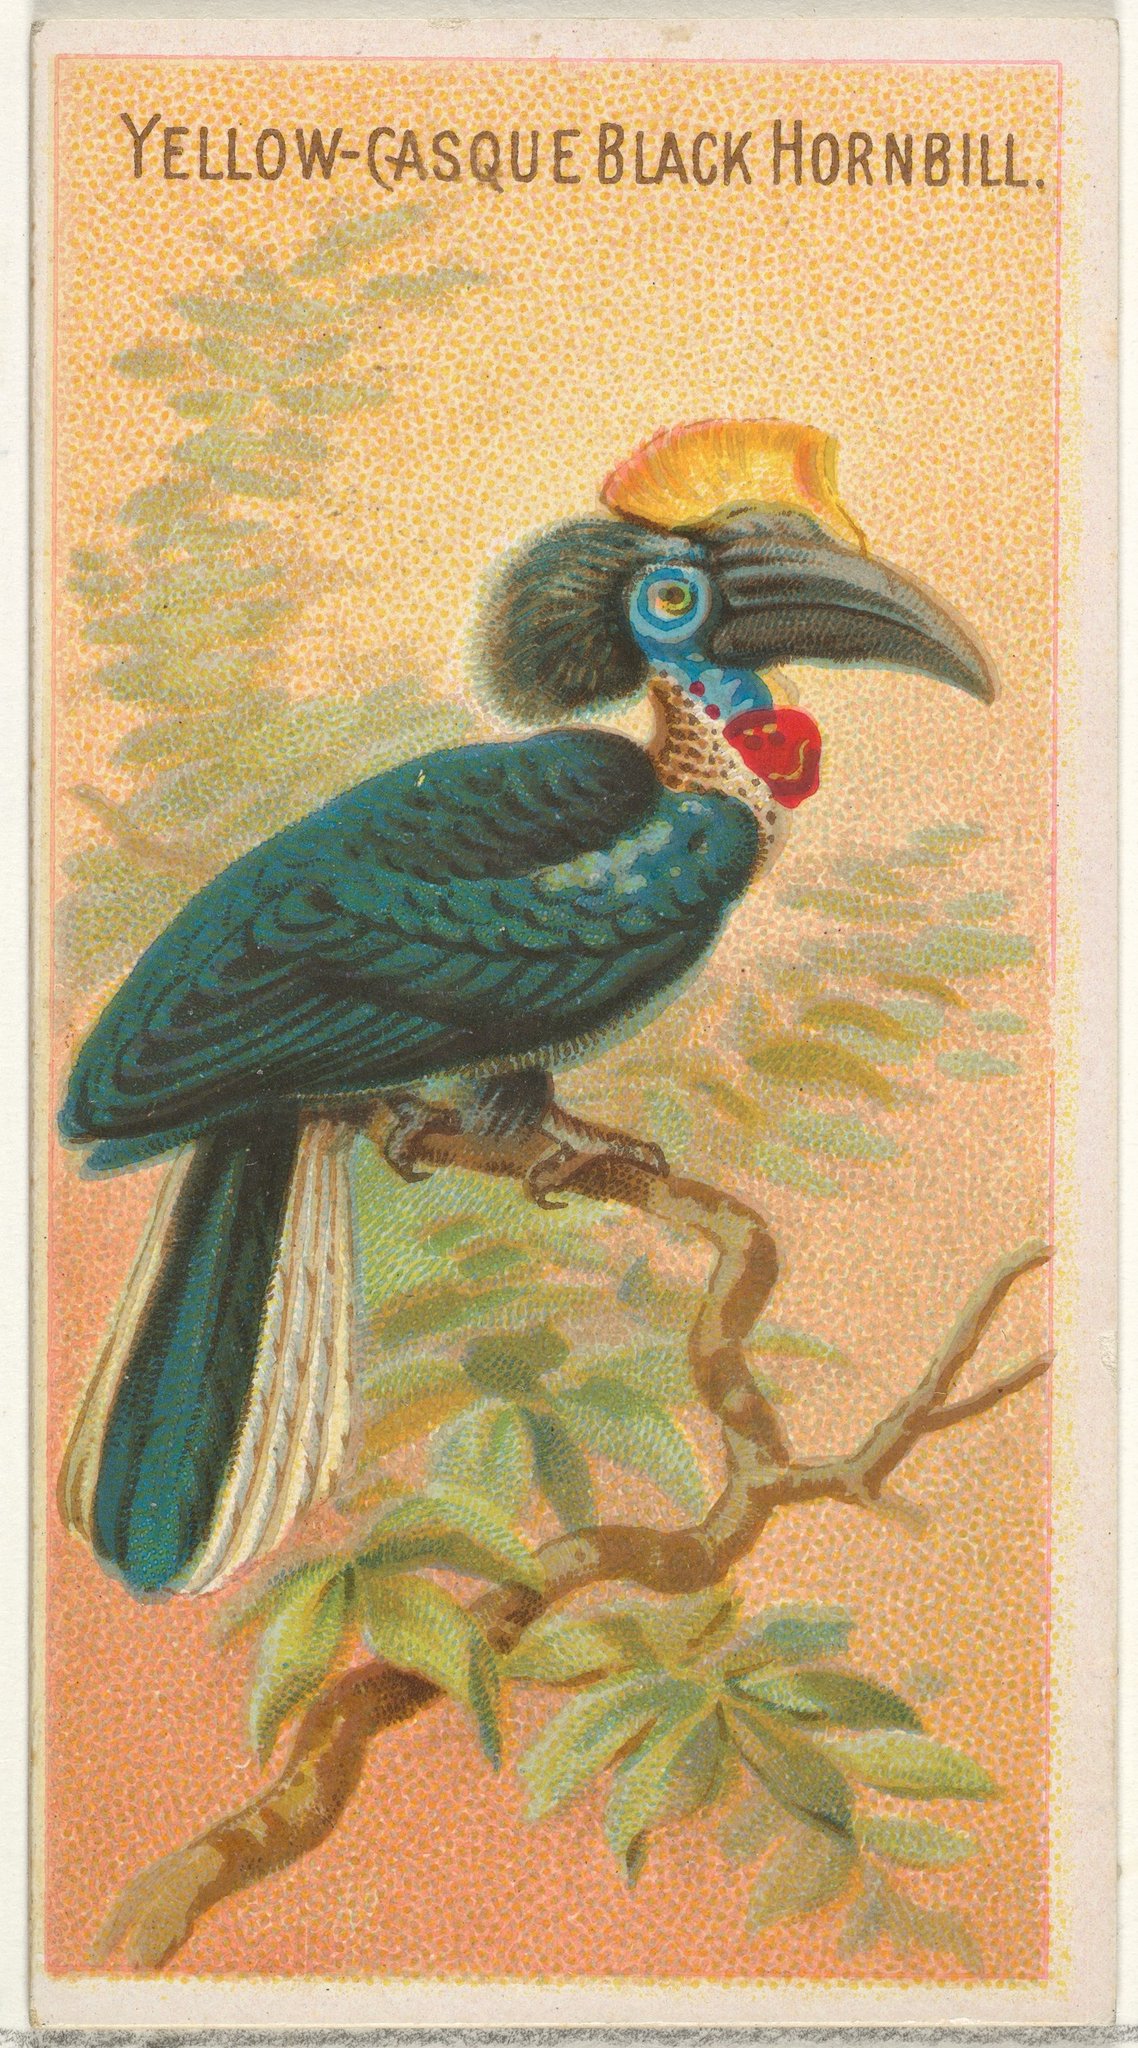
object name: print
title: Yellow-Casque Black Hornbill, from the Birds of the Tropics series (N5) for Allen & Ginter Cigarettes Brands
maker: allen & ginter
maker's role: publisher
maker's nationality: american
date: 1889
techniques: color lithograph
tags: birds